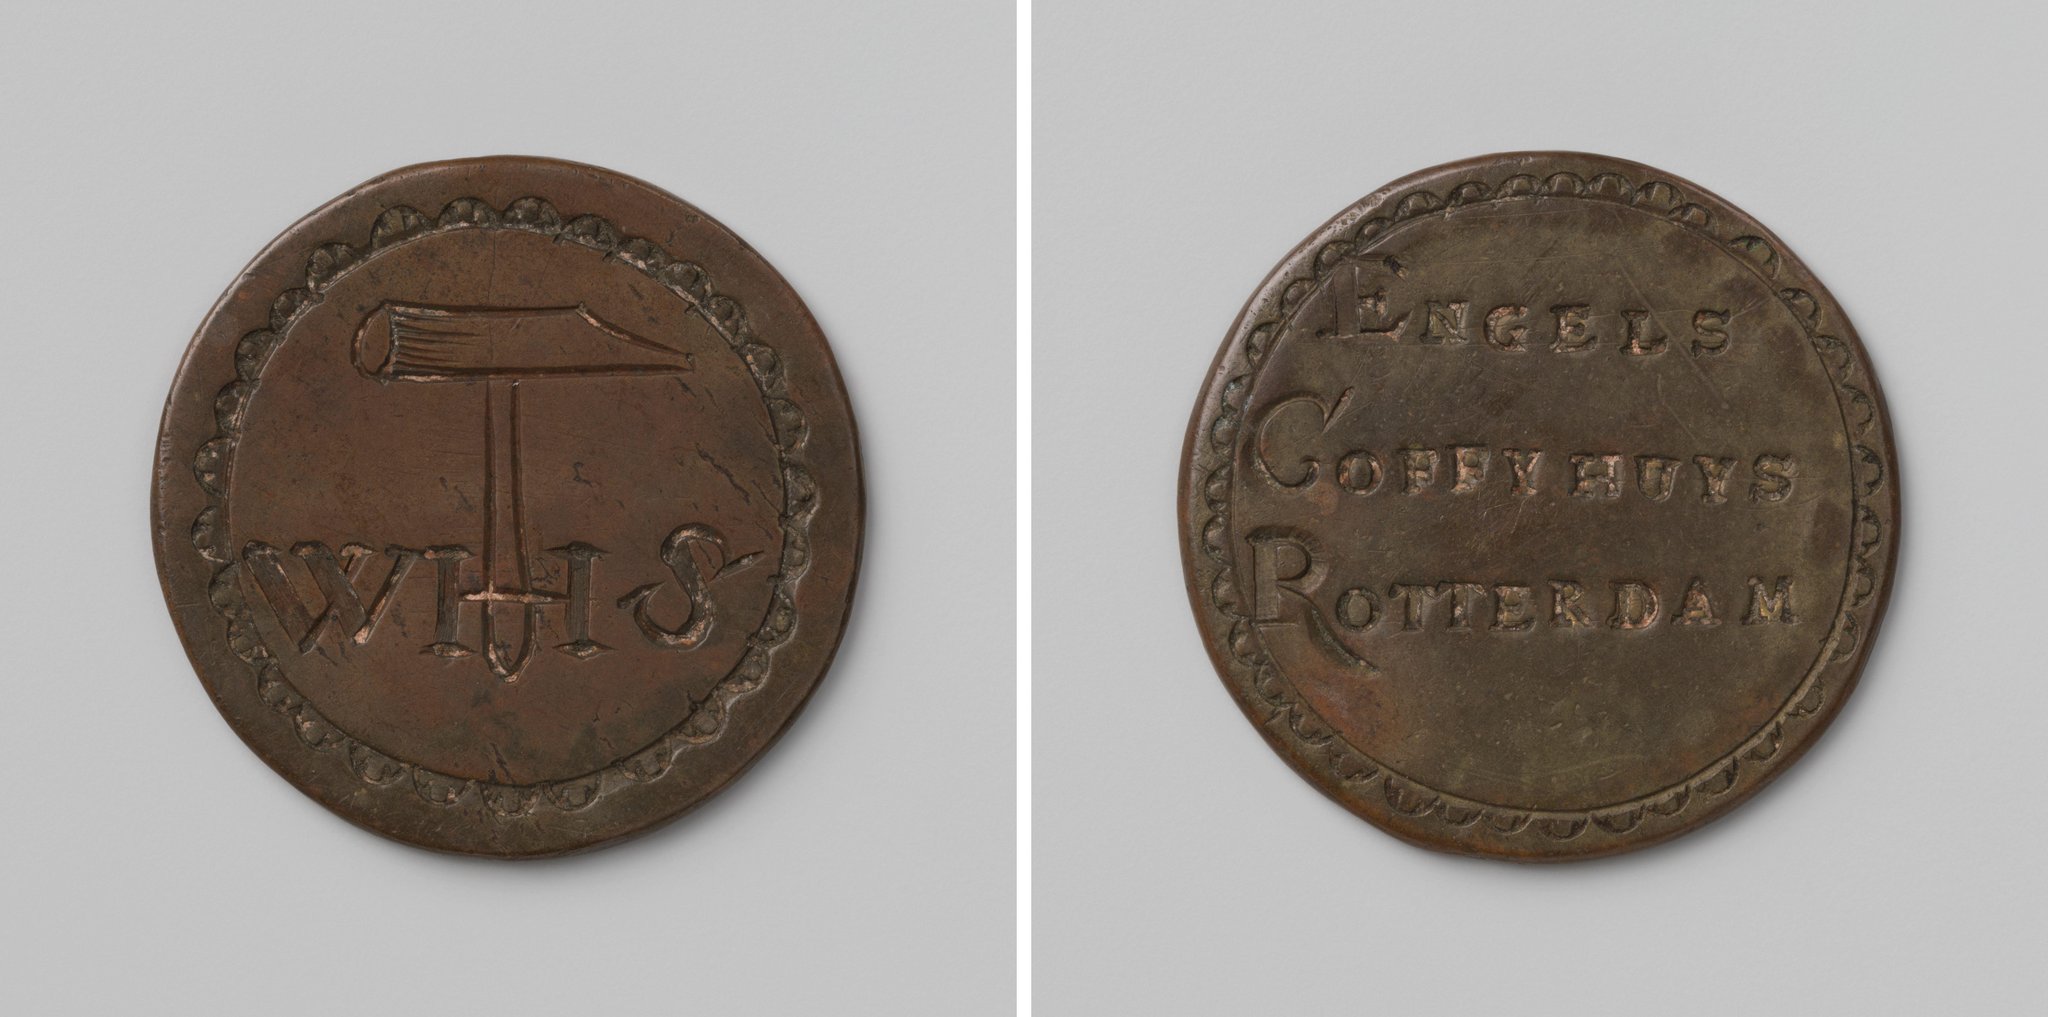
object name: medal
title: Timmerliedengilde, penning van het Engels Coffyhuys (koffiehuis) te Rotterdam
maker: Anonymous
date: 1800-1900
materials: brass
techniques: engraving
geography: netherlands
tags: rotterdam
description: Messing penning. Voorzijde: hamer boven monogram van letters W, H en S binnen sierrand. Keerzijde: opschrift binnen sierrand. Vermoedelijk een gildepenning.